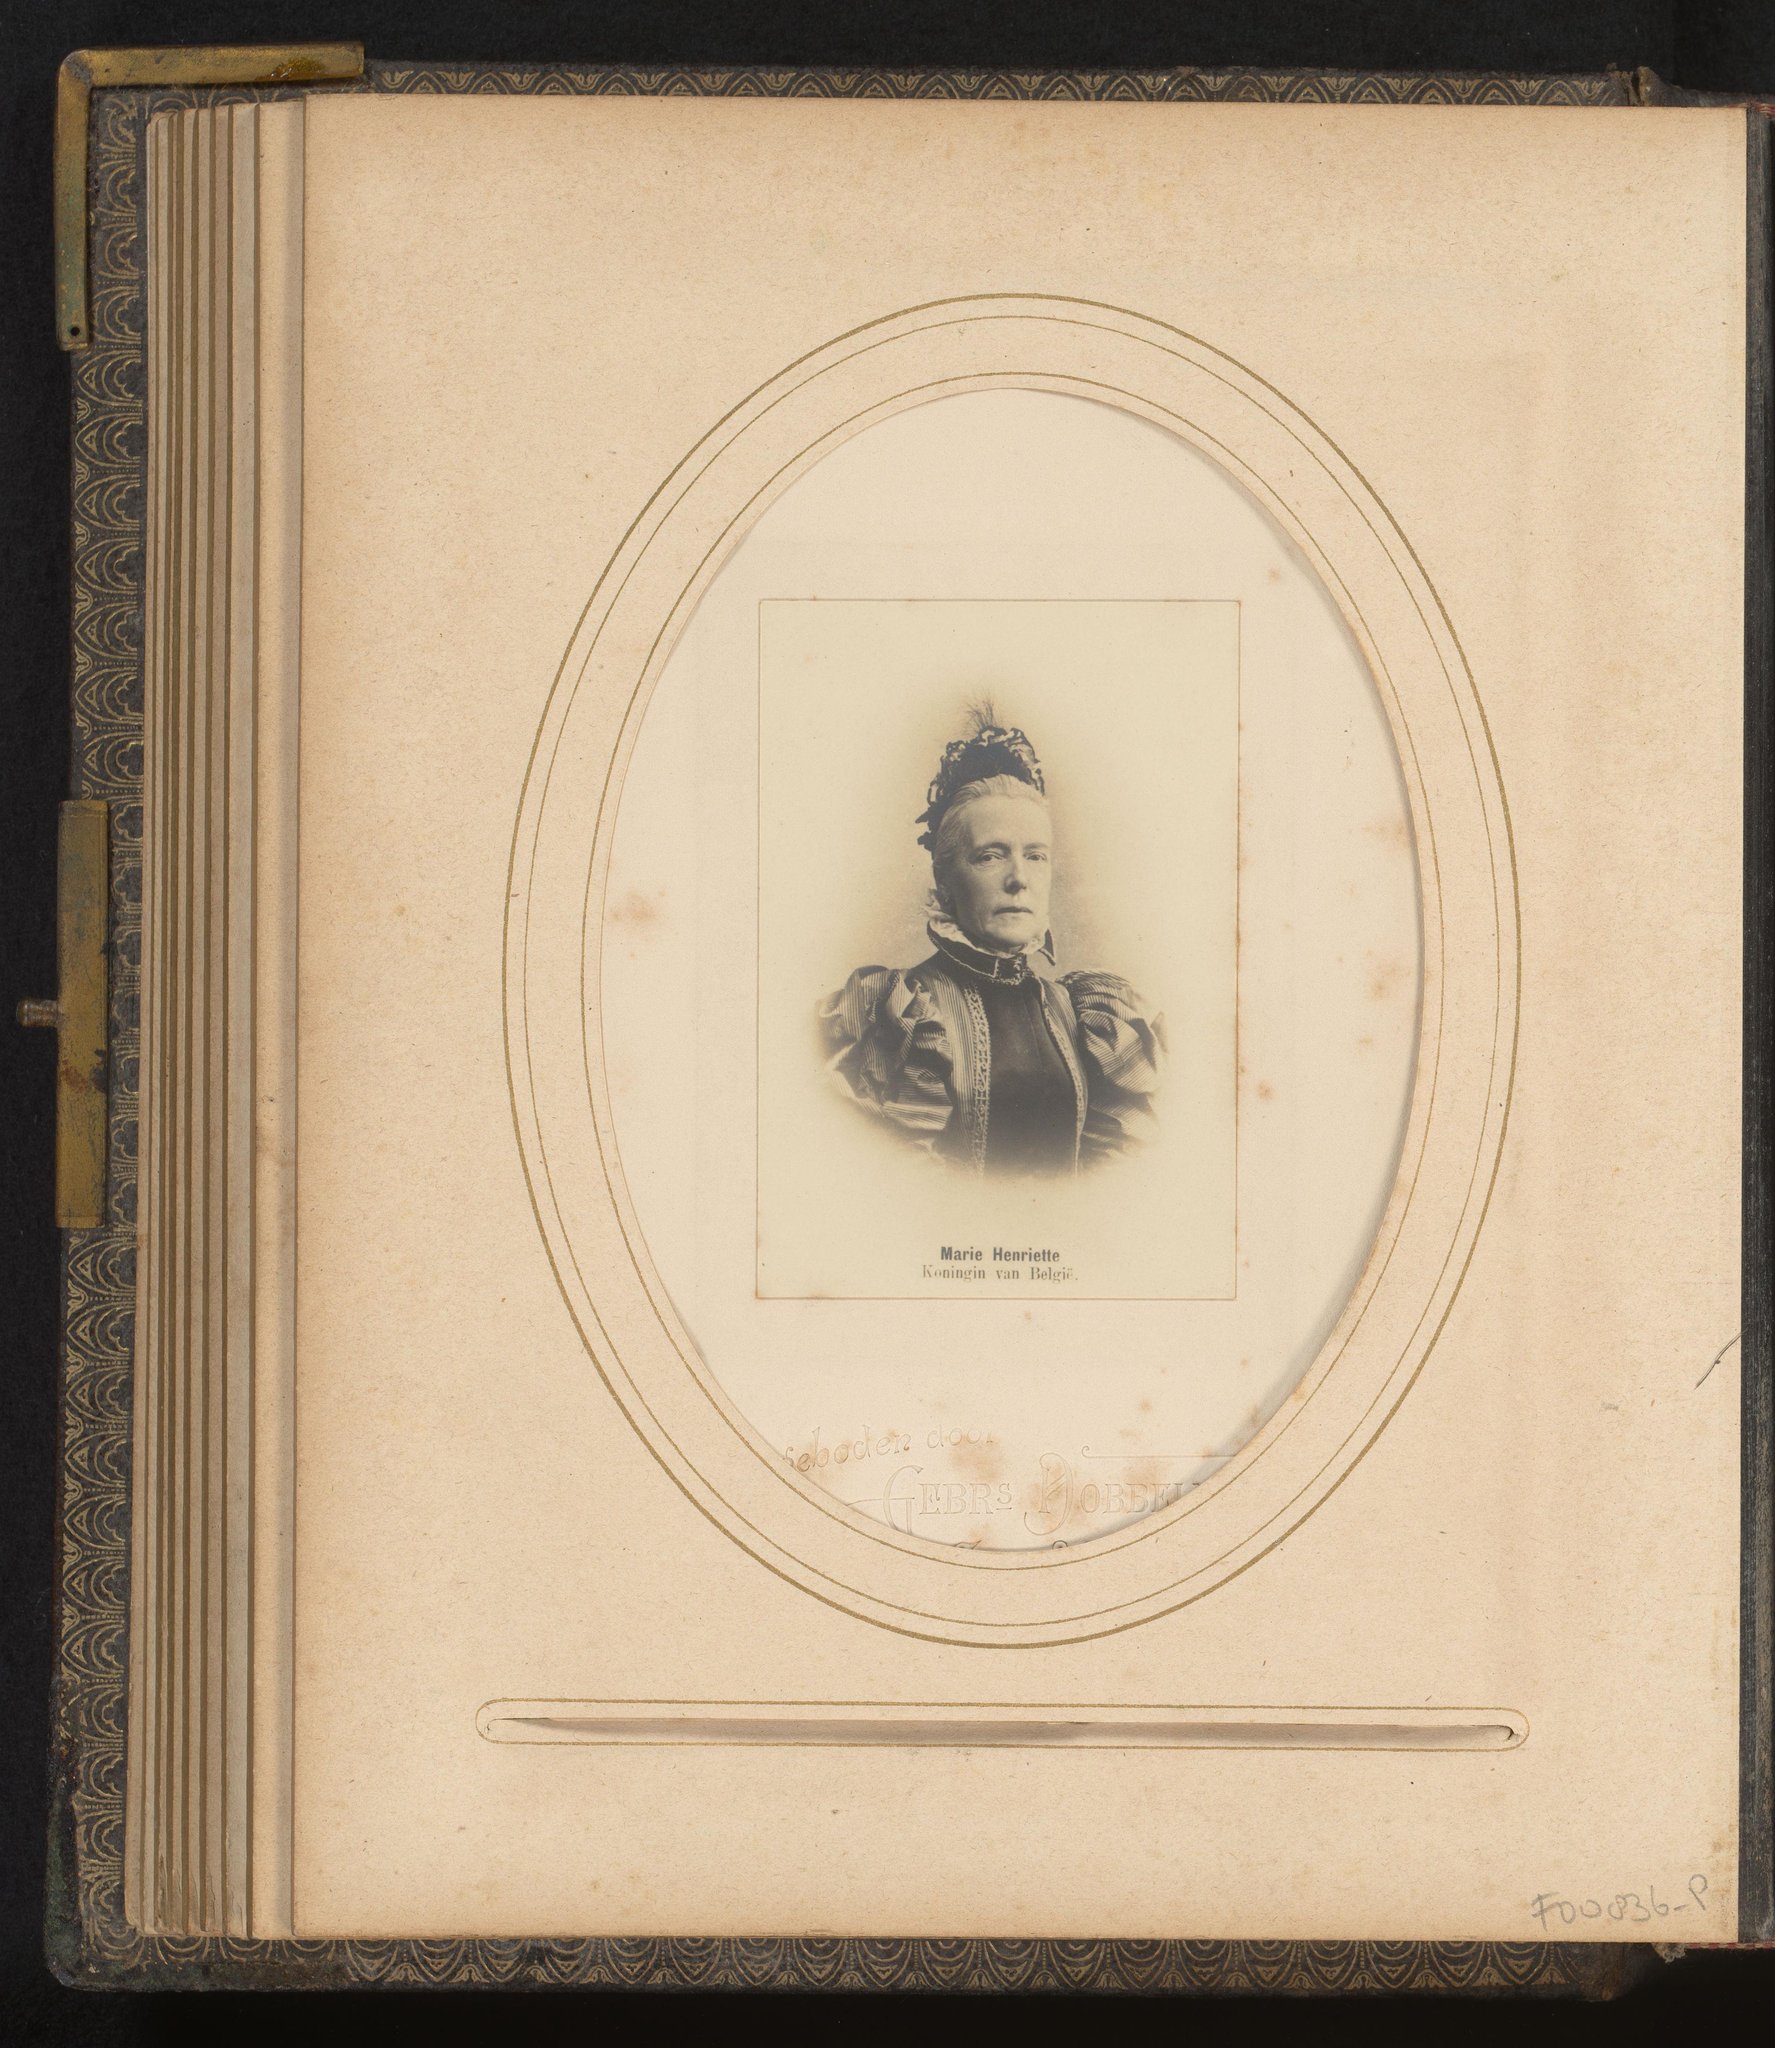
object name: cabinet photograph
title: Marie Henriette koninging van België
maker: Anonymous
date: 1880-1900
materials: cardboard, photographic support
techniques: gelatin silver print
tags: historical persons - bb - woman, queen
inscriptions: inscription: ‘Aangeboden door/ Gebrs. Dobbelmann/ zeepfabrikanten/ Nijmegen/ Serie 1 No. 4’